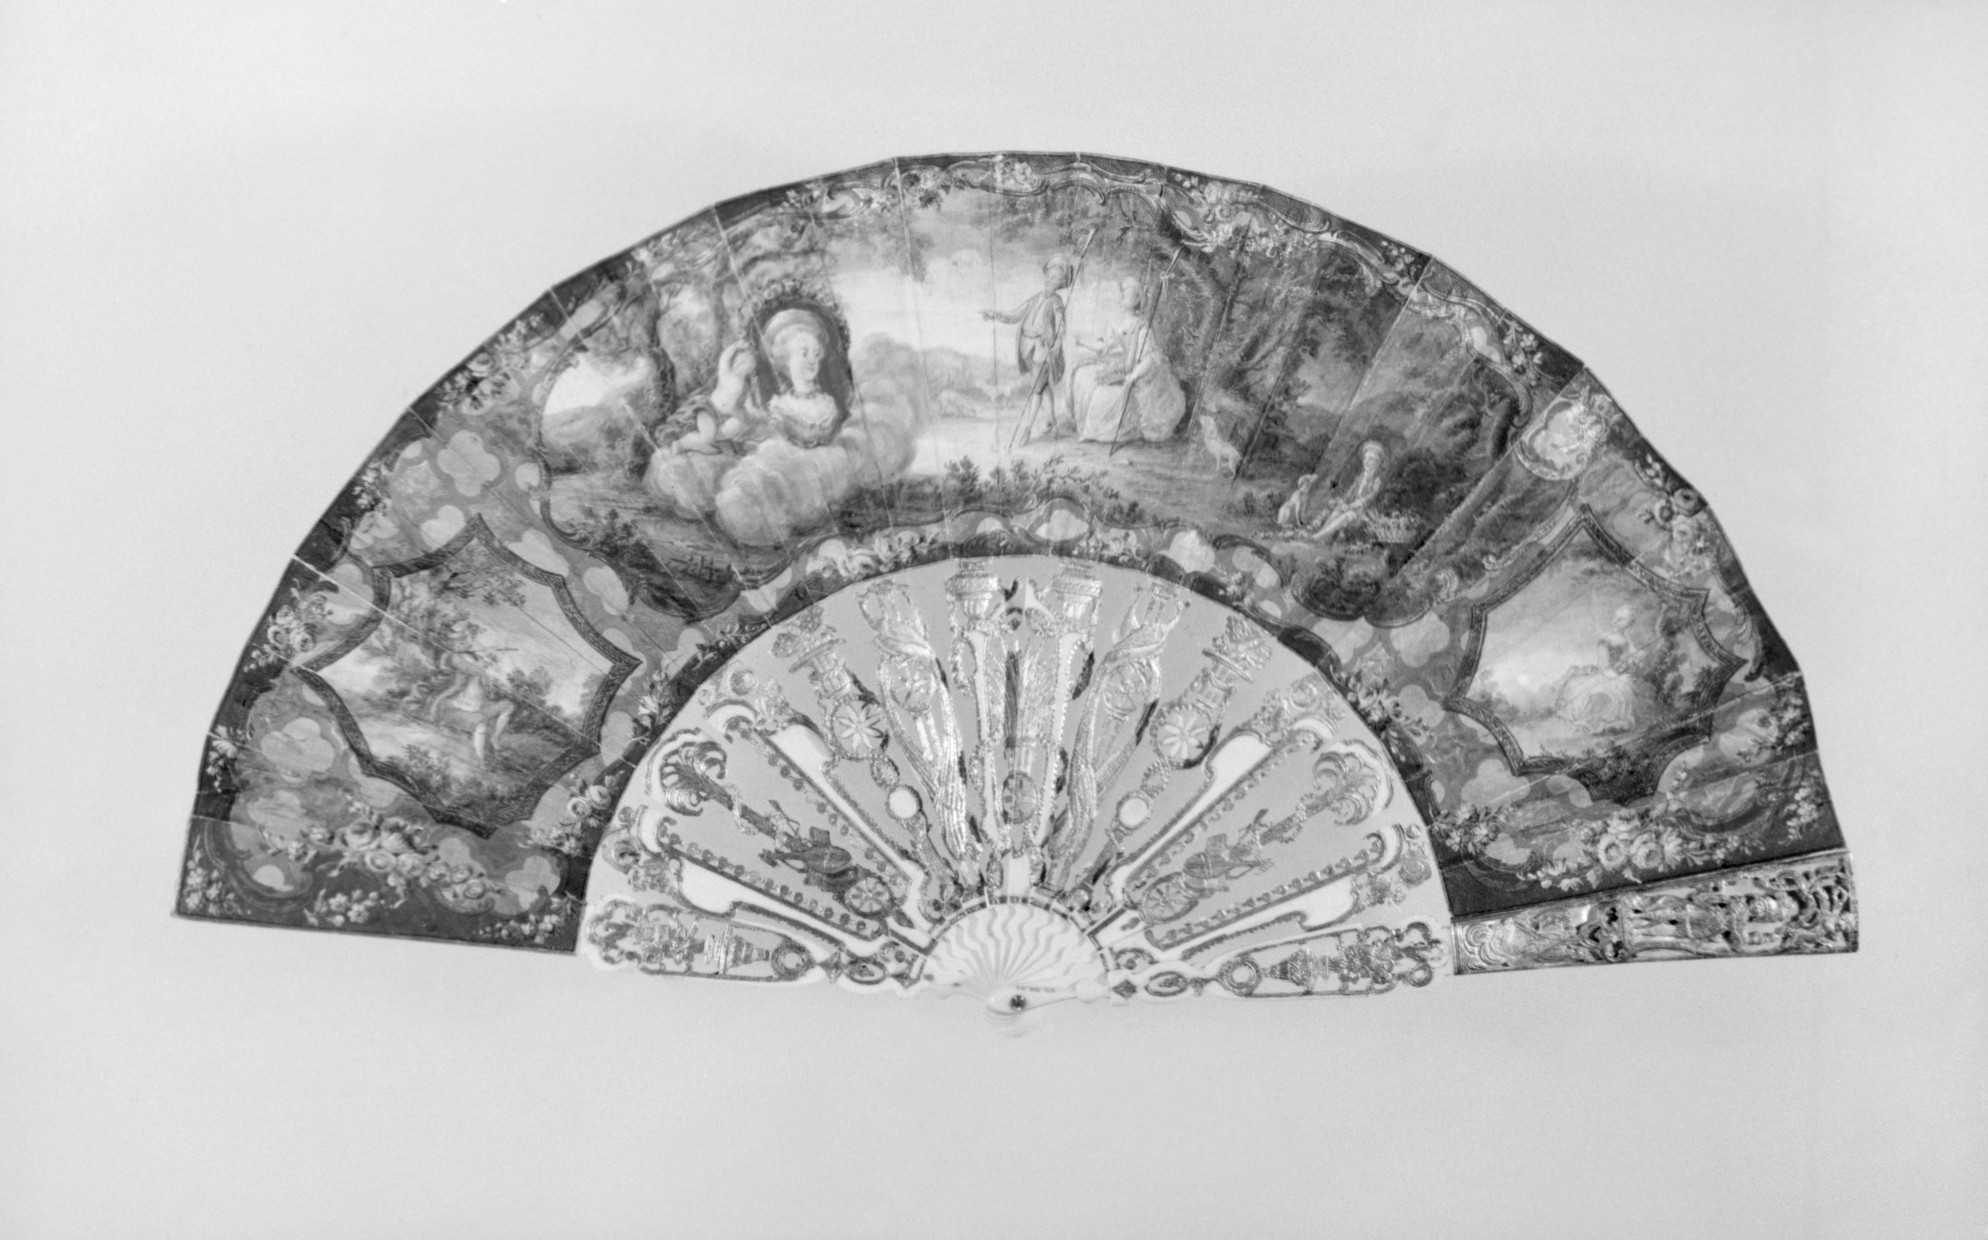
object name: fan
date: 1701-1800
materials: ivory, paper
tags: men,women,dogs